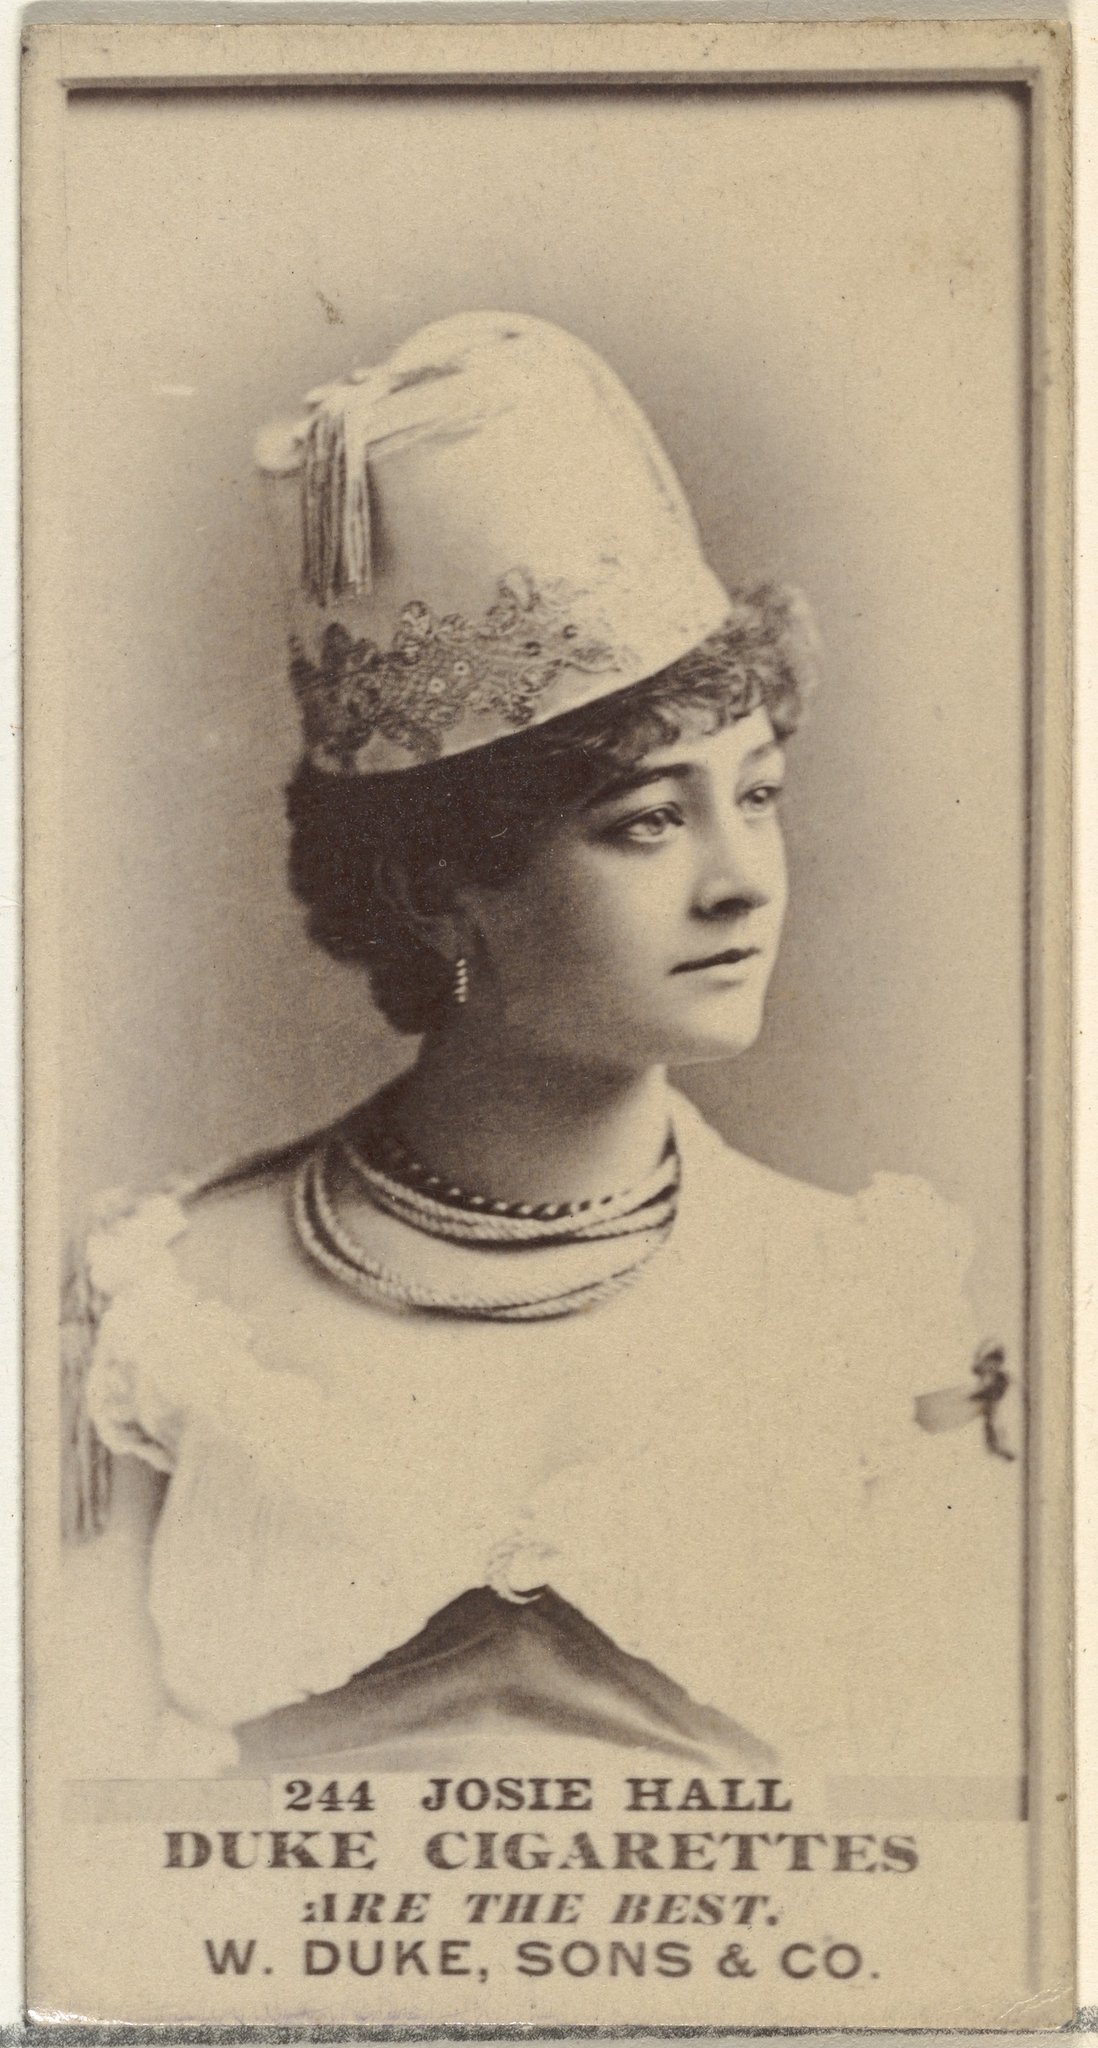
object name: photograph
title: Card Number 244, Josie Hall, from the Actors and Actresses series (N145-7) issued by Duke Sons & Co. to promote Duke Cigarettes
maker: w. duke, sons & co.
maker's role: publisher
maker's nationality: american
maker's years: 1870-1920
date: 1880-1889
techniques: albumen silver print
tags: portraits,women,actresses